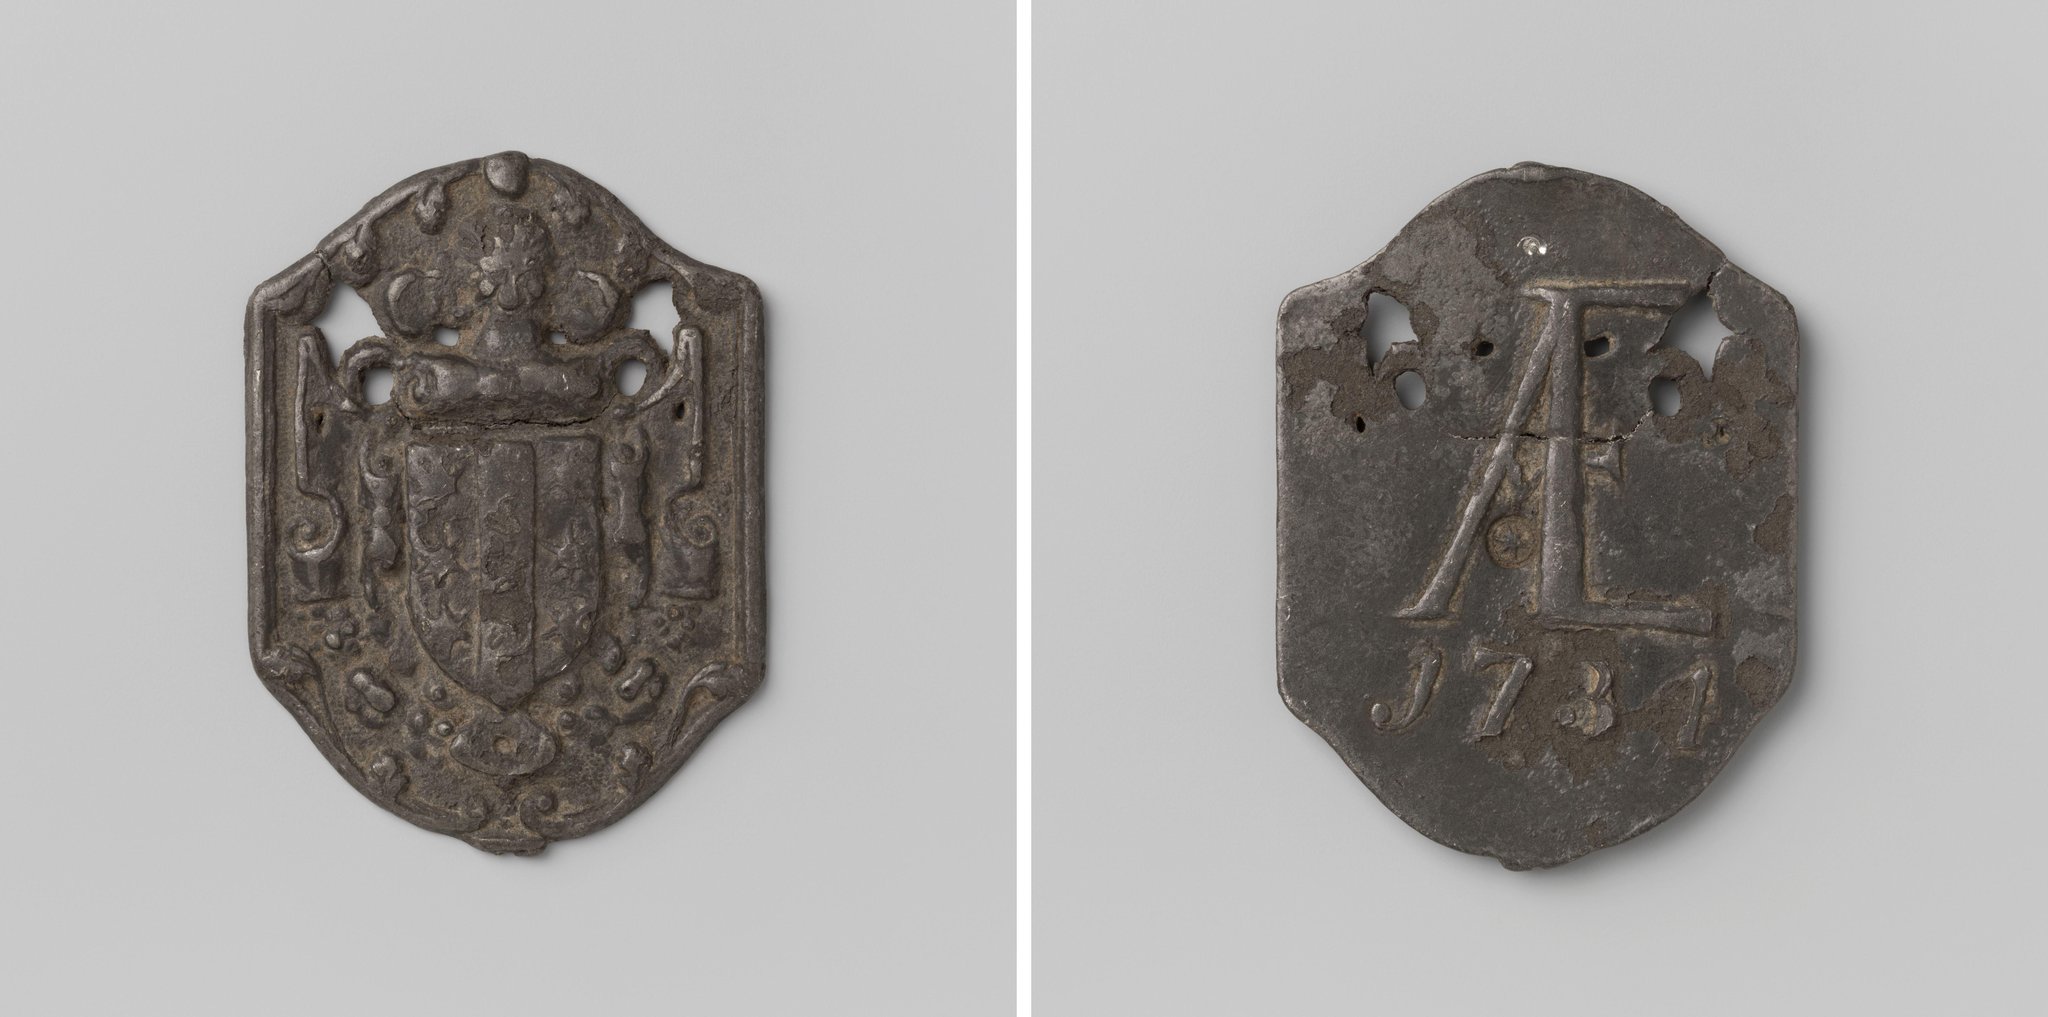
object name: turfloodje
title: Stad Gouda, loodje goed voor een ton turf en een gift in geld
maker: Anonymous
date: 1734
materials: lead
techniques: casting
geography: gouda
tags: gouda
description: penning van onregelmatige vorm. Voorzijde: wapenschild in sierlijk cartouche. Keerzijde: monogram van letters A en E boven jaartal; tussen letters A en E klop: zespuntige ster